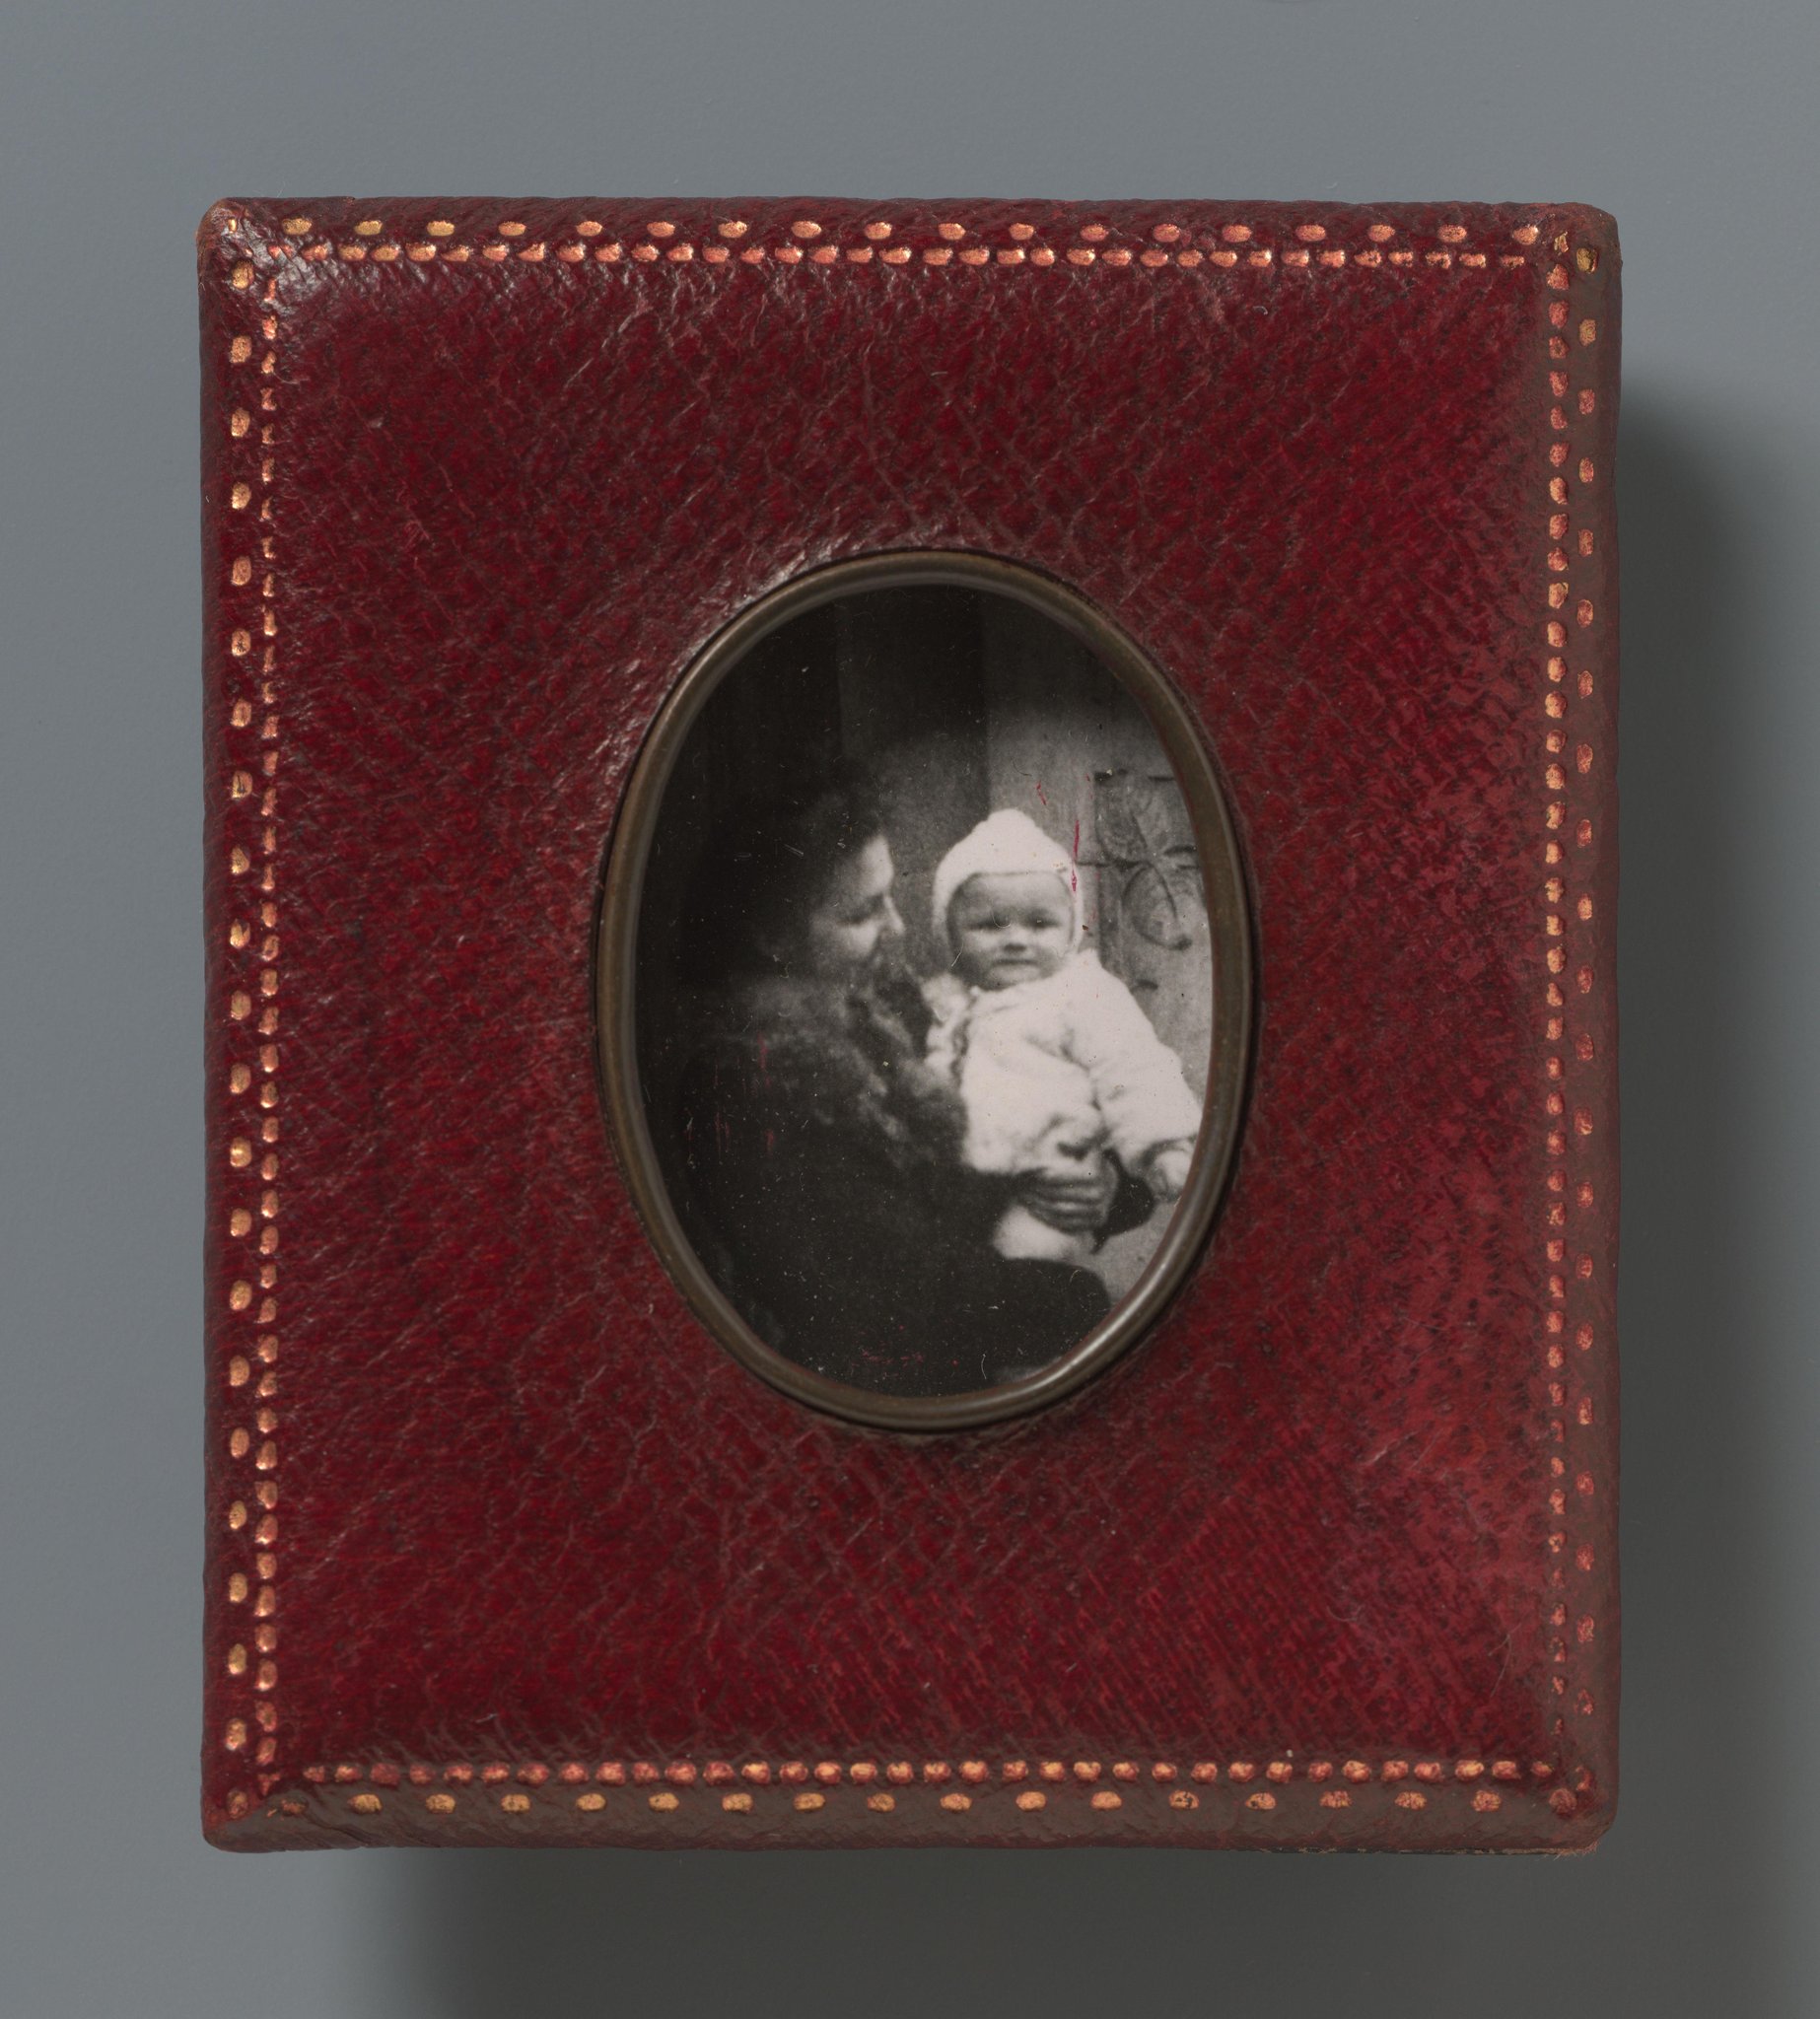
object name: photograph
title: Moeder met baby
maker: Anonymous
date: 1900-1930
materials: paper, cardboard, glass, leather, metal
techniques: gelatin silver print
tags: mother and baby or young child